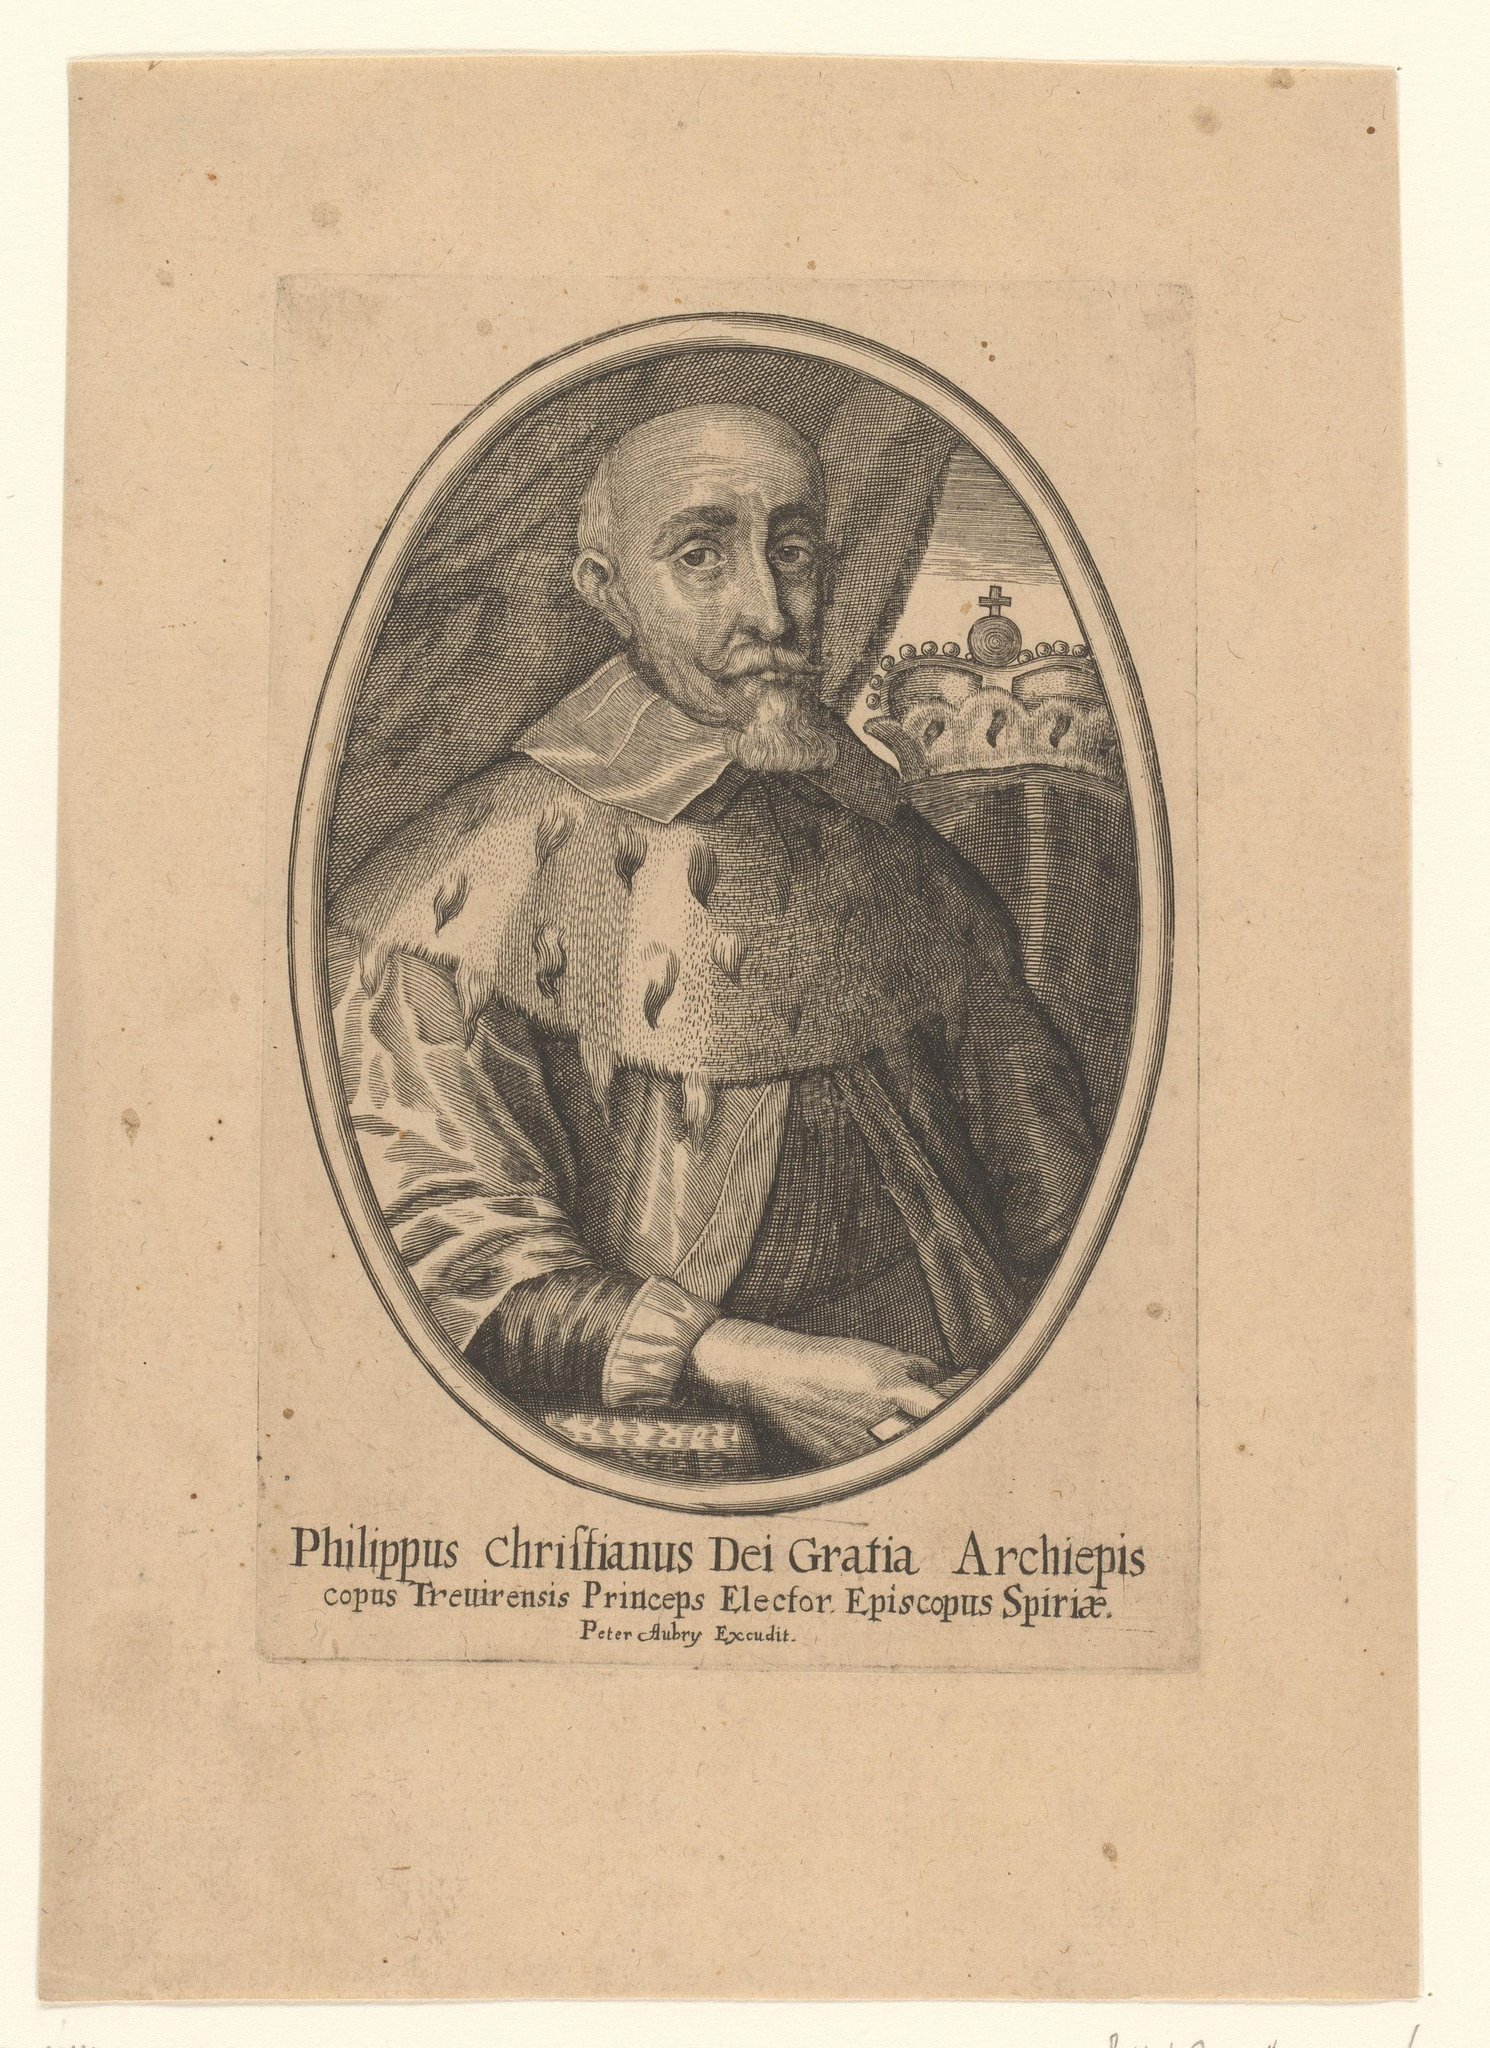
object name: print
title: Portret van Philipp Christoph von Sötern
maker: Anonymous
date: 1646-1647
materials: paper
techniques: engraving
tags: archbishop, bishop, etc. (roman catholic), historical persons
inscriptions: collector's mark: Lugt 2228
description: Prent waarschijnlijk uit: Schleder, Johann Georg. Theatrum Europaeum. Frankfurt am Main: erven Matthäus Merian, 1647, dl. 5. Komt mogelijk ook voor in de tweede druk uit 1651 en in de derde druk uit 1707.